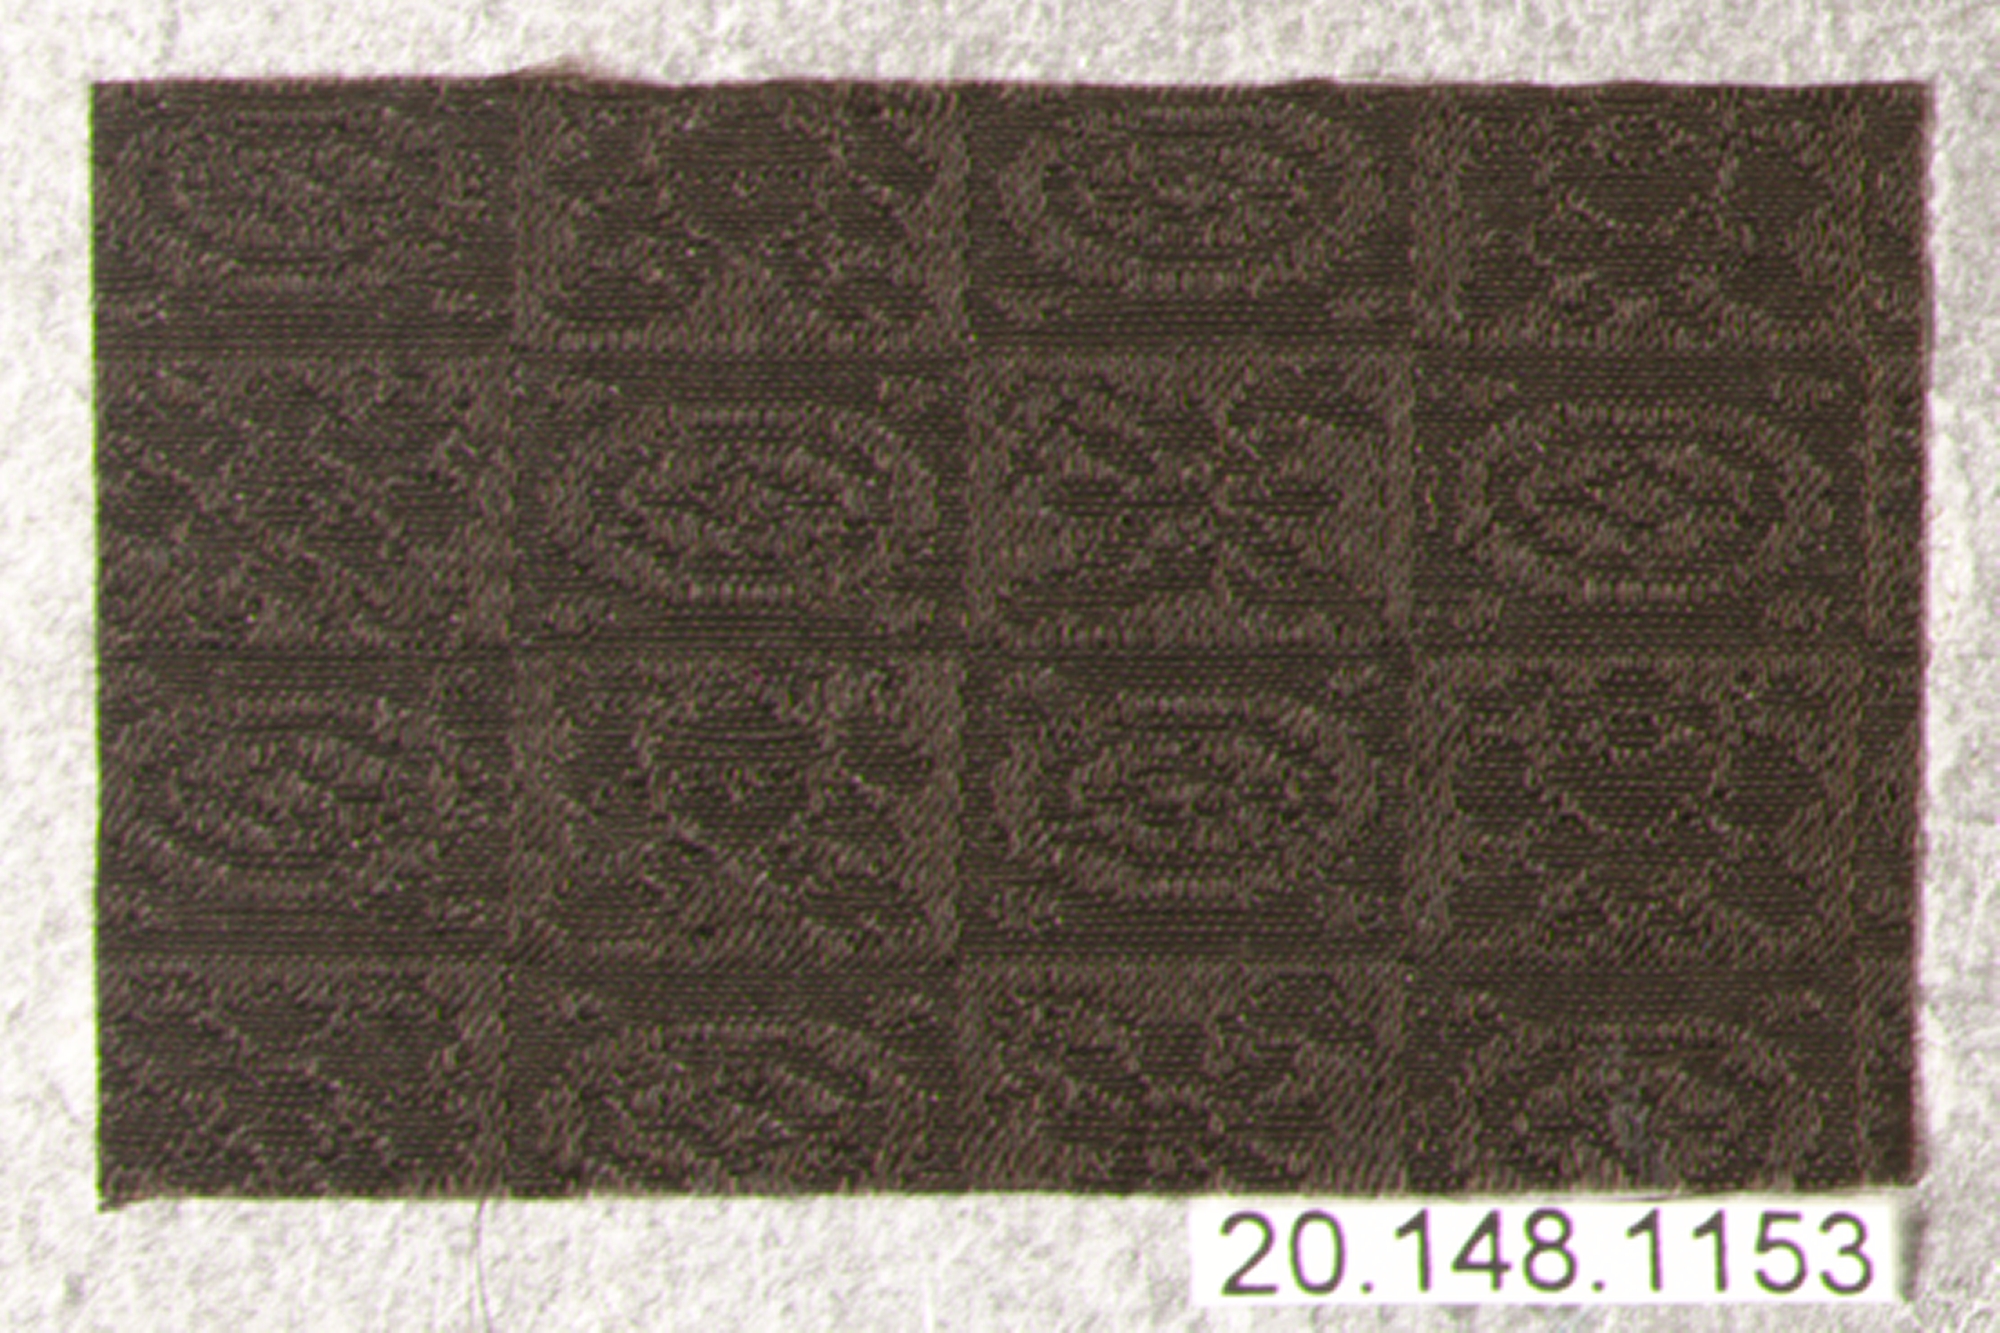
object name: piece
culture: japanese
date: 1801-1900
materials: silk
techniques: compound weave